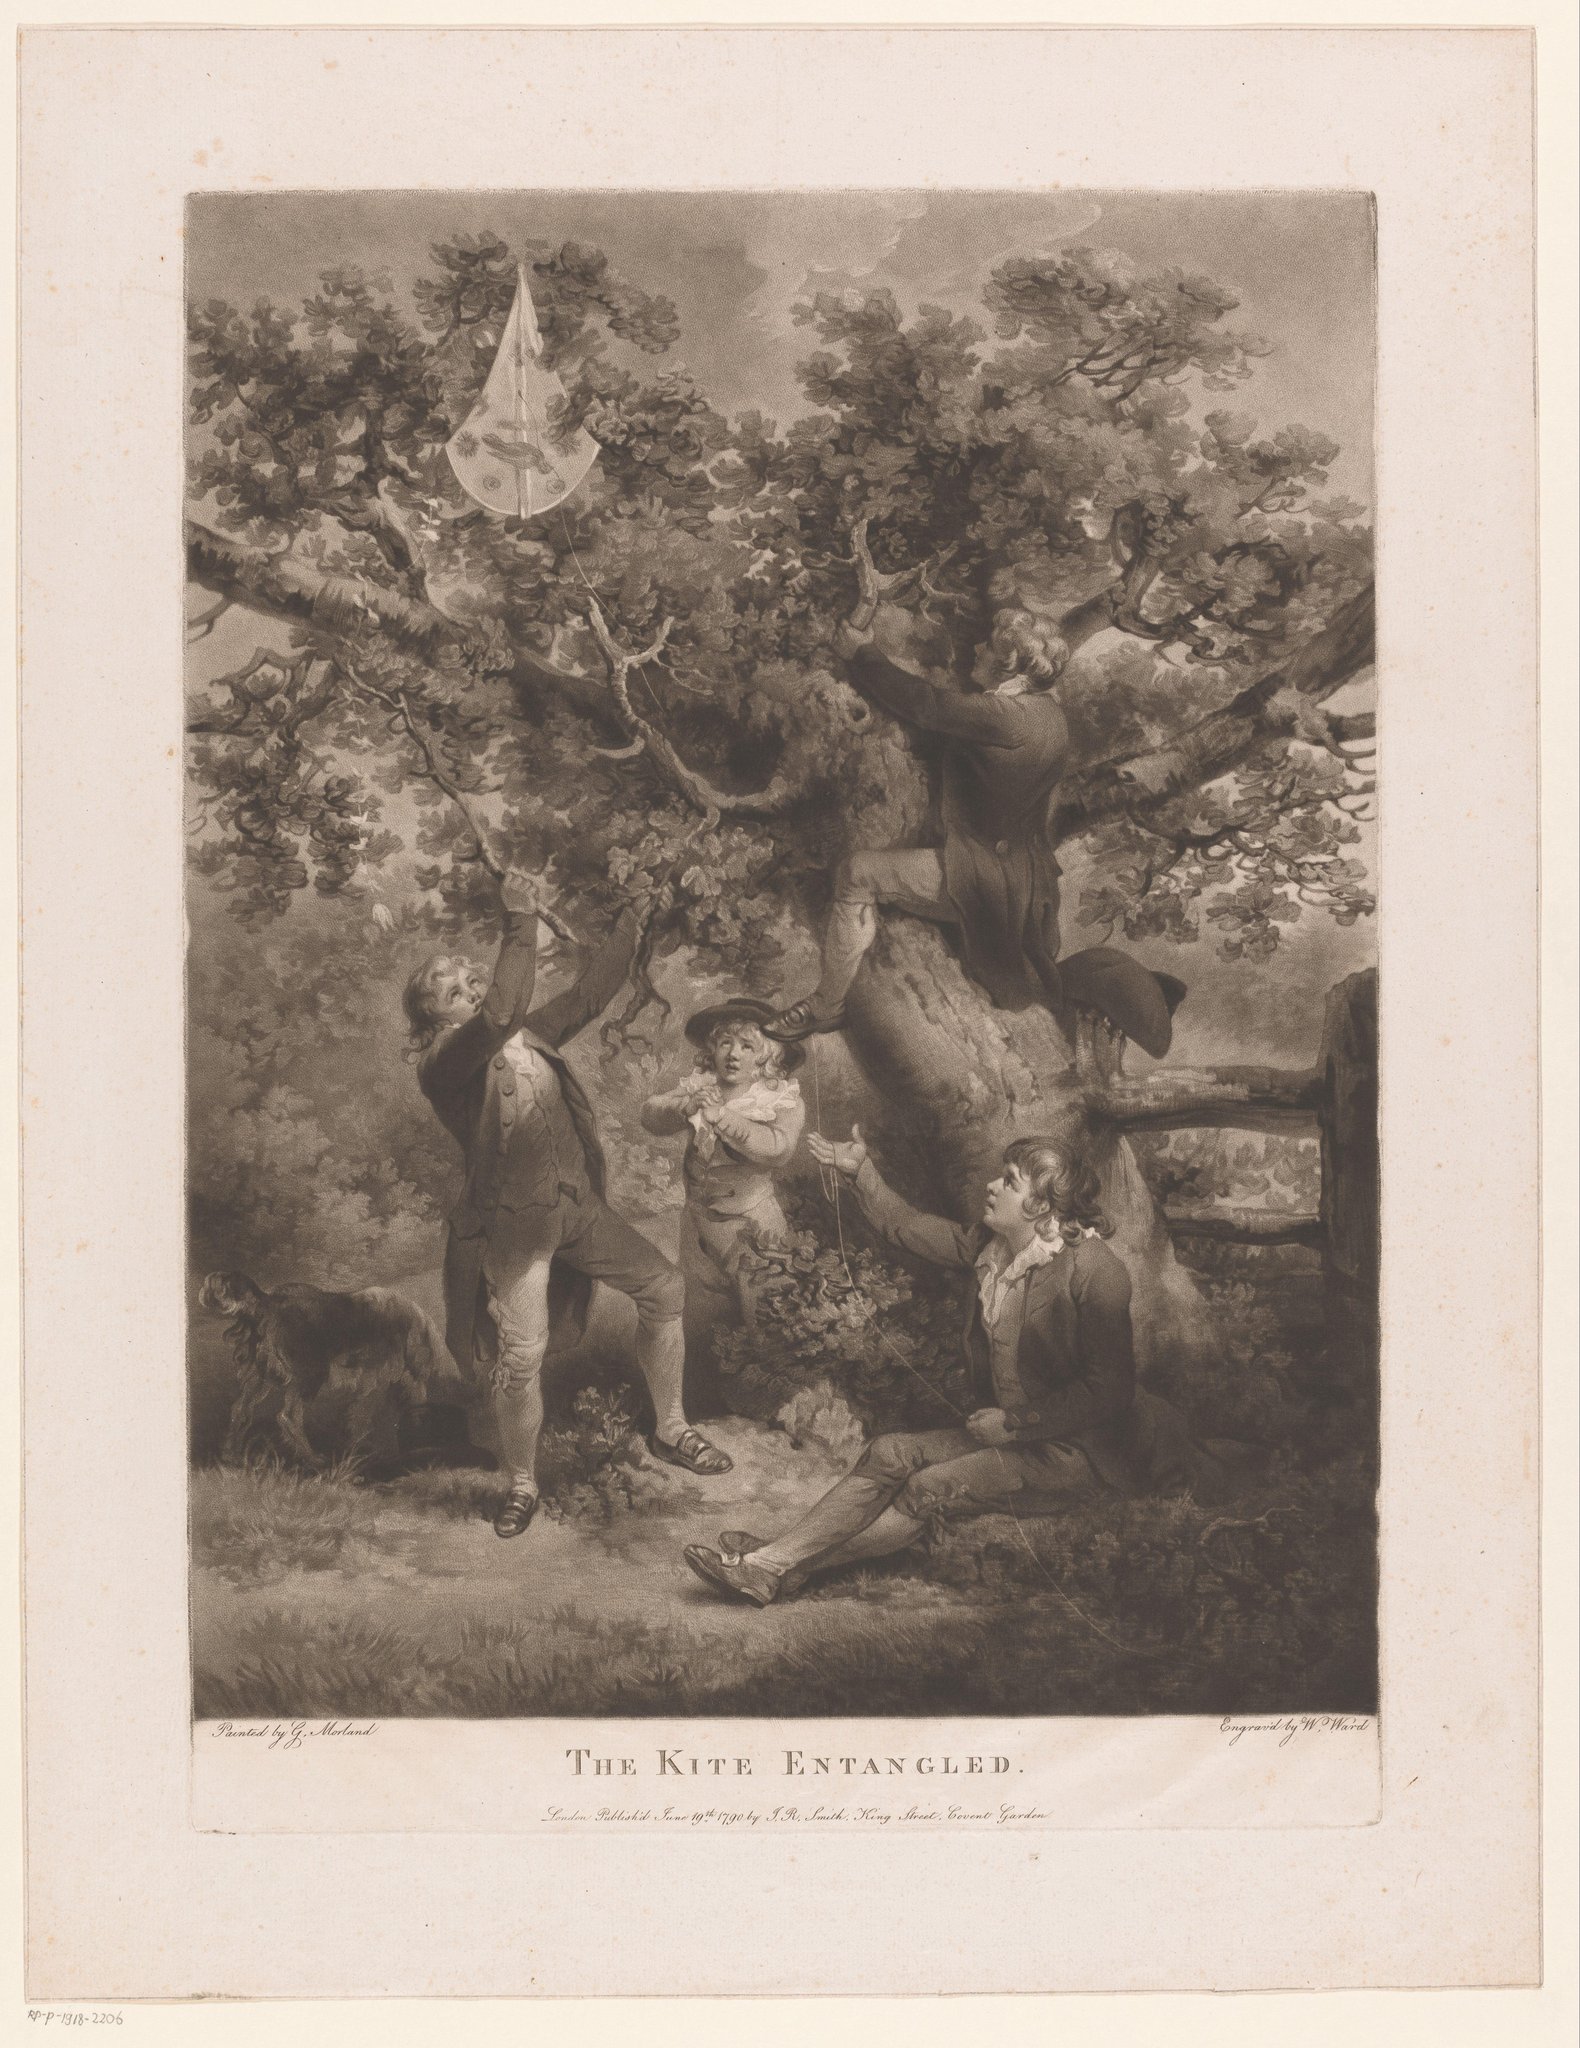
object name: print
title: Jongens proberen een vlieger uit een boom los te maken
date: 1790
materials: paper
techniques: mezzotint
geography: london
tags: boy (child between toddler and youth), (flying a) kite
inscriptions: collector's mark: Lugt 2233